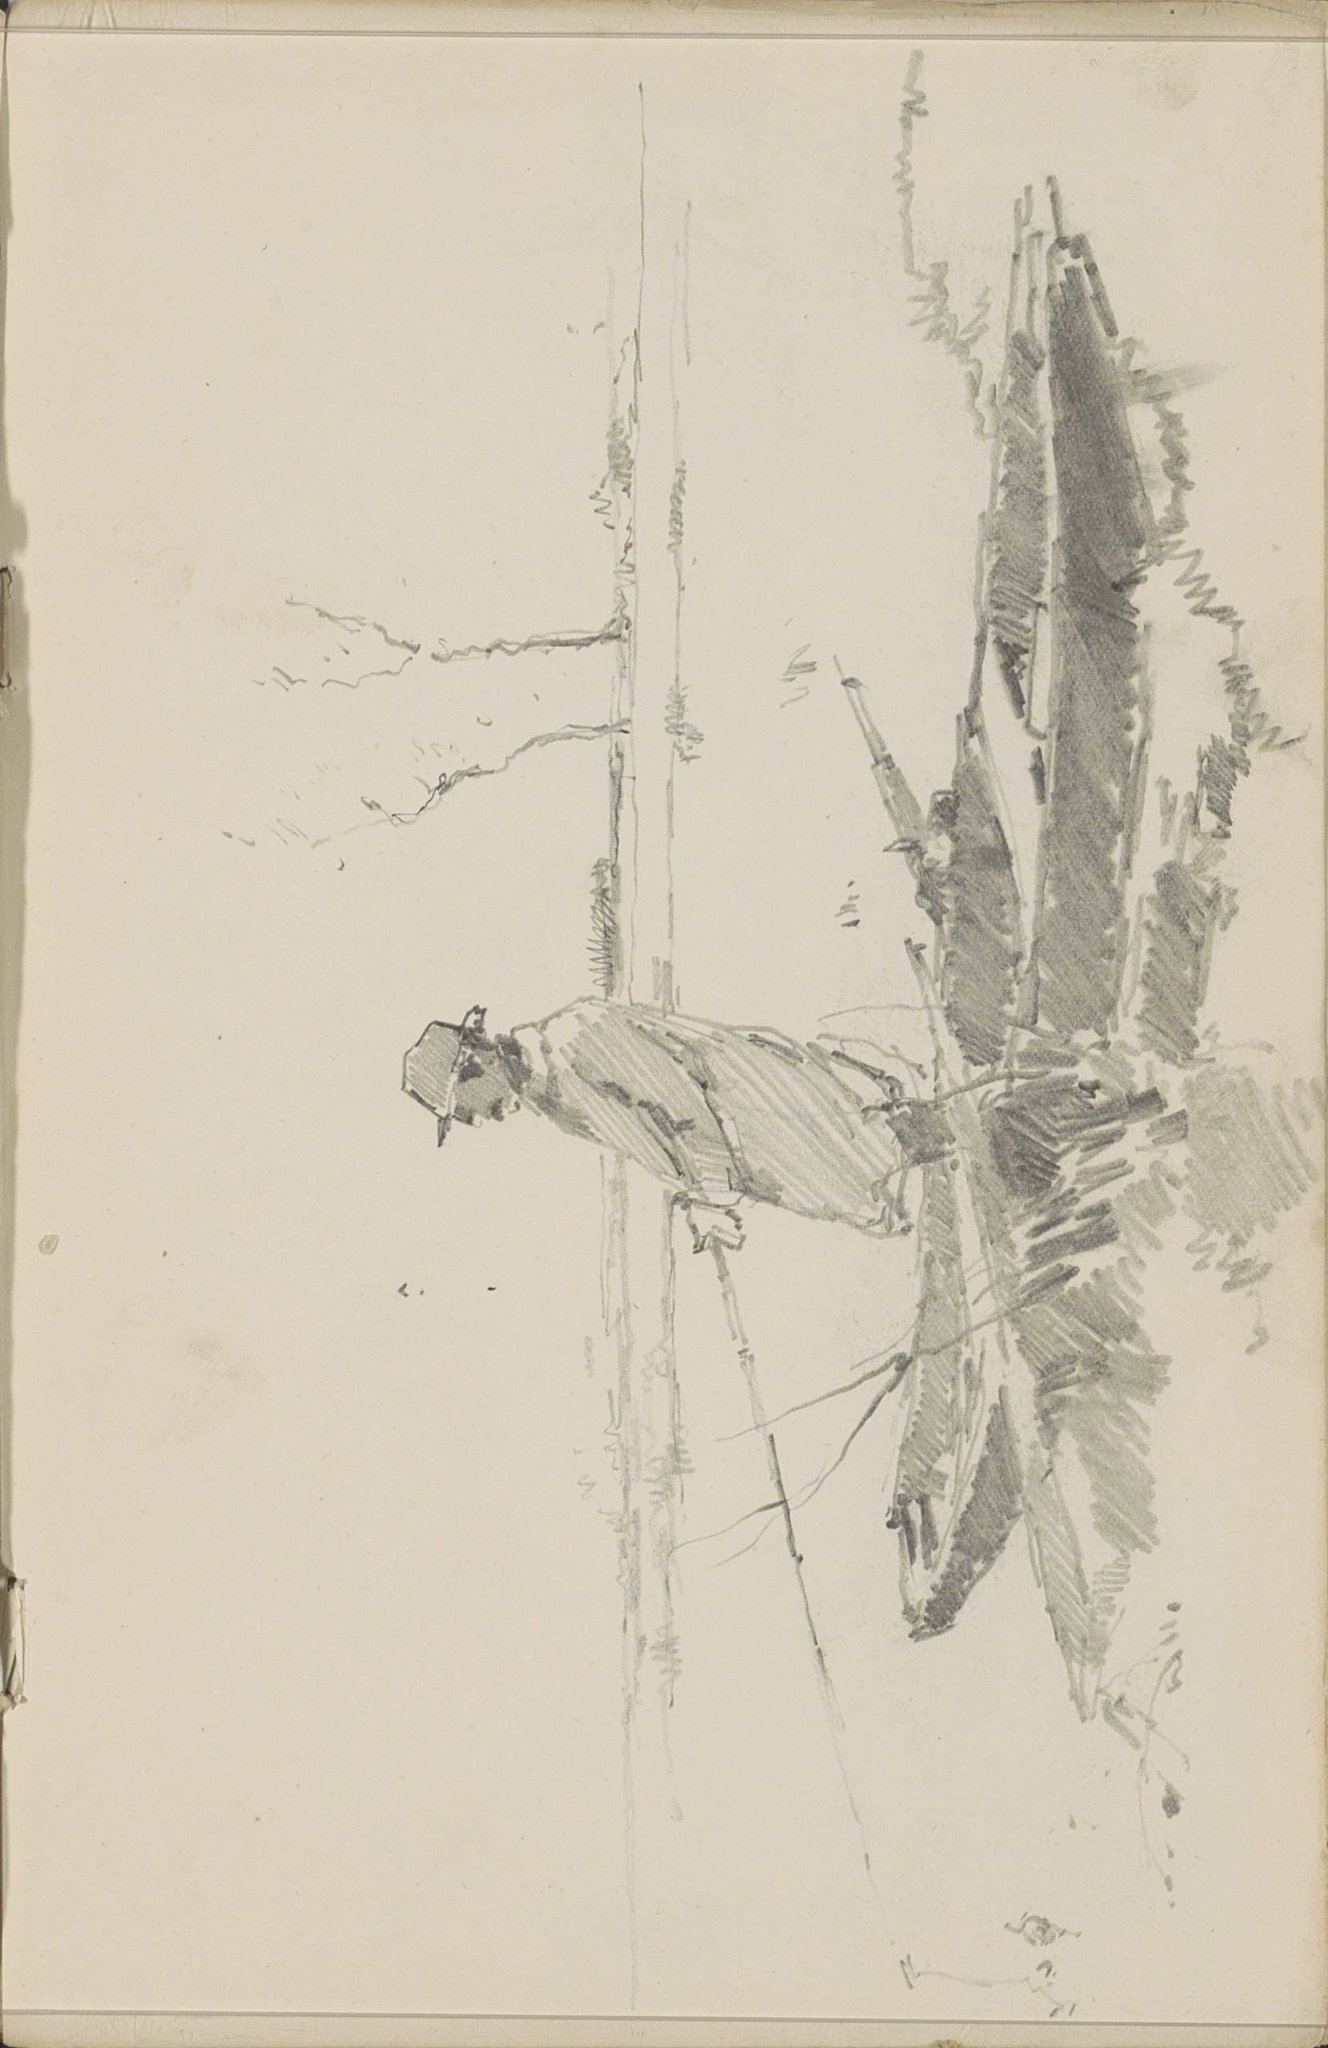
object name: sketchbook leaf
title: Vissende man in een roeiboot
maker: cornelis vreedenburgh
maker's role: draughtsman, print maker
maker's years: 1880-1946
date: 1890-1946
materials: paper, pencil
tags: rowing-boat, canoe, etc., landscapes with waters, waterscapes, seascapes (in the temperate zone) (+ landscape with figures, staffage), fisherman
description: Blad 35 recto uit een schetsboek met 45 bladen.